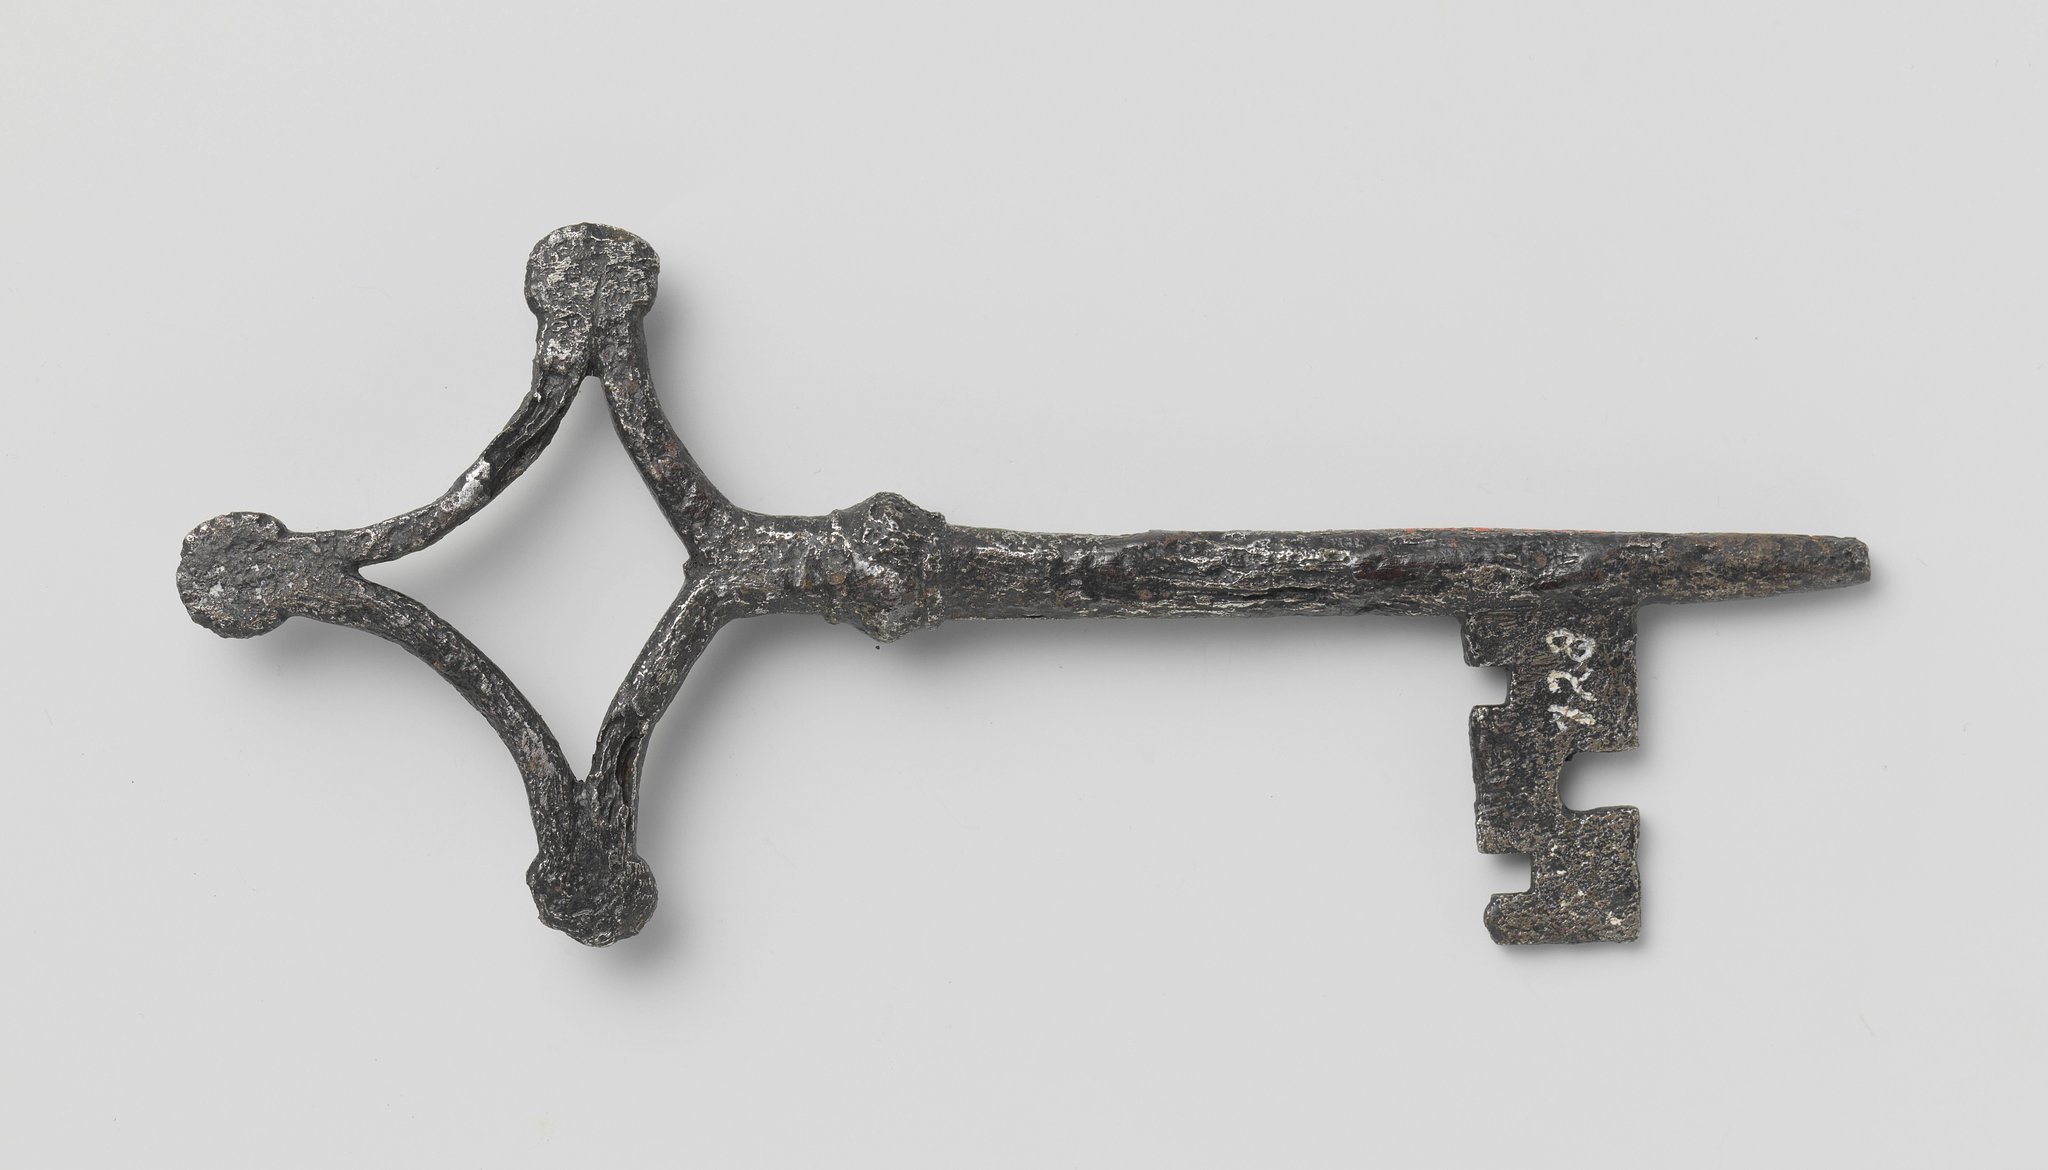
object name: key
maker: Anonymous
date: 1400-1500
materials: iron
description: Sleutel waarvan de greep enigszins ruitvormig is, met concave zijden. Op de drie hoeken is een St. Jacobsschelp aangebracht. De schacht die onder de greep een nodus heeft, loopt onder de baard spitts toe.